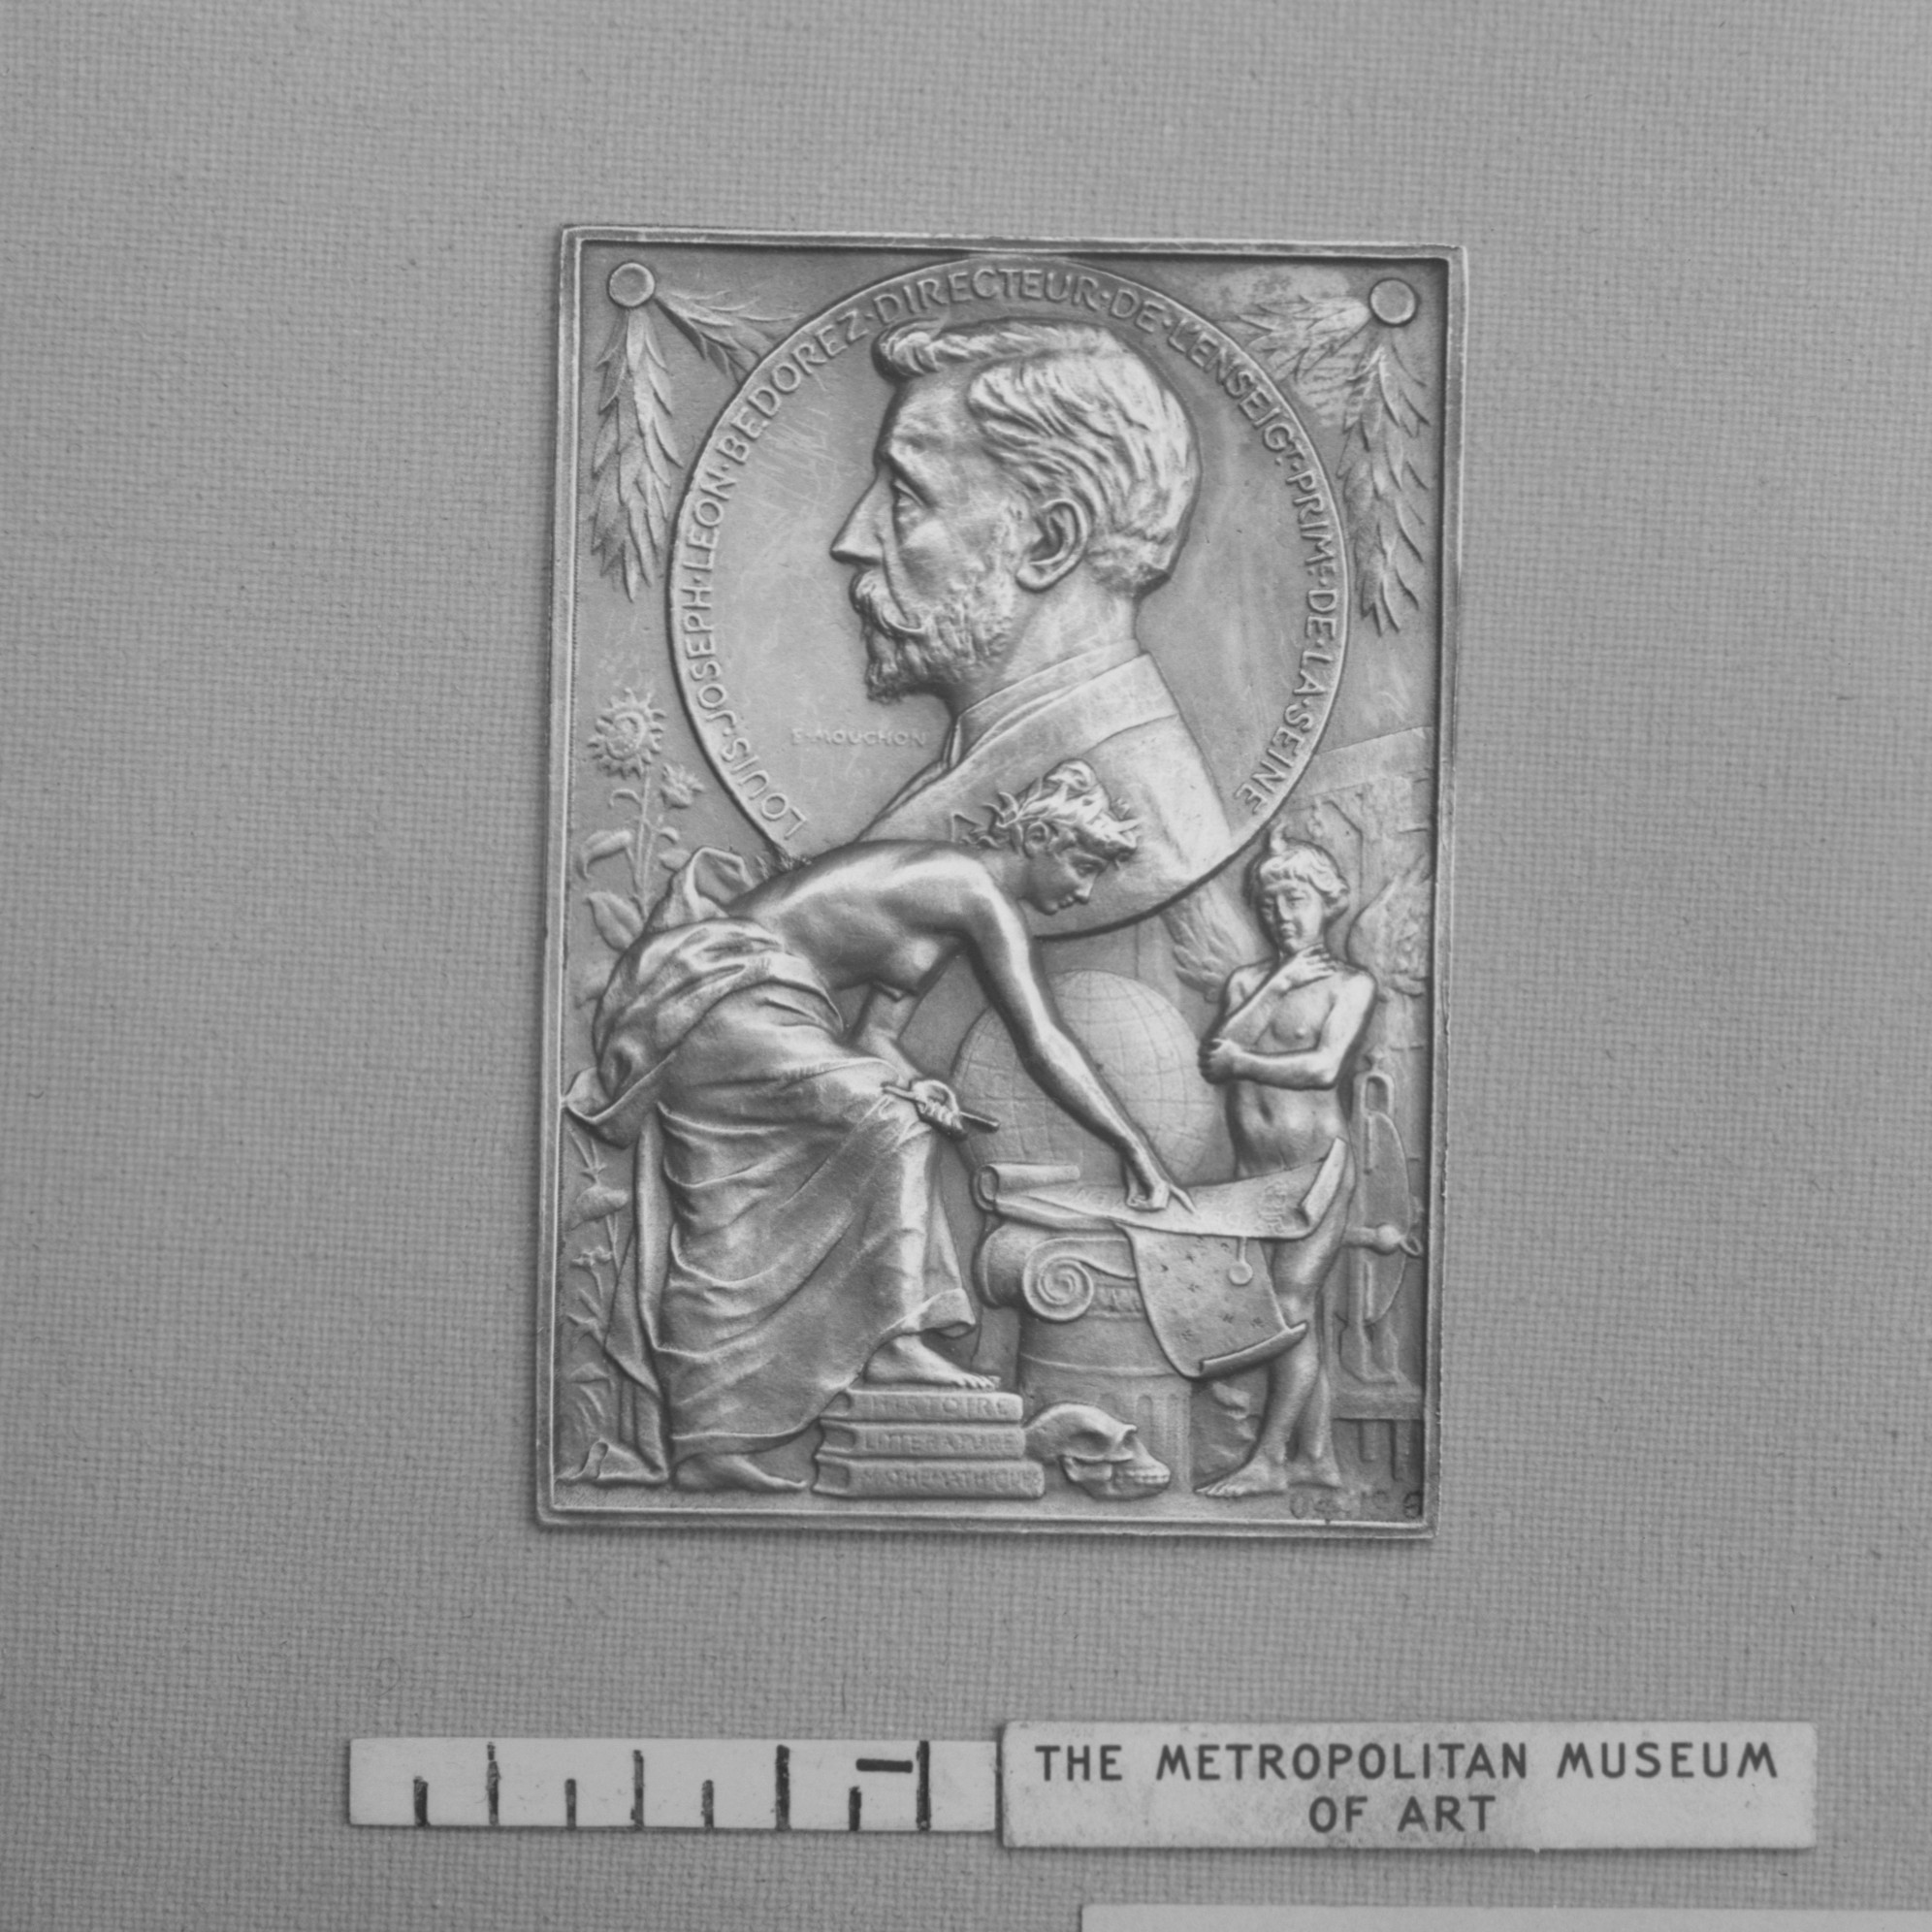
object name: plaquette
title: In Honor of M. Bédorez, Former Director of Primary Education in the Department of the Seine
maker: louis eugène mouchon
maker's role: artist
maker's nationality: french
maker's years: 1843-1914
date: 1867-1900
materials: bronze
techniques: silvered, struck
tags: men,profiles,female nudes